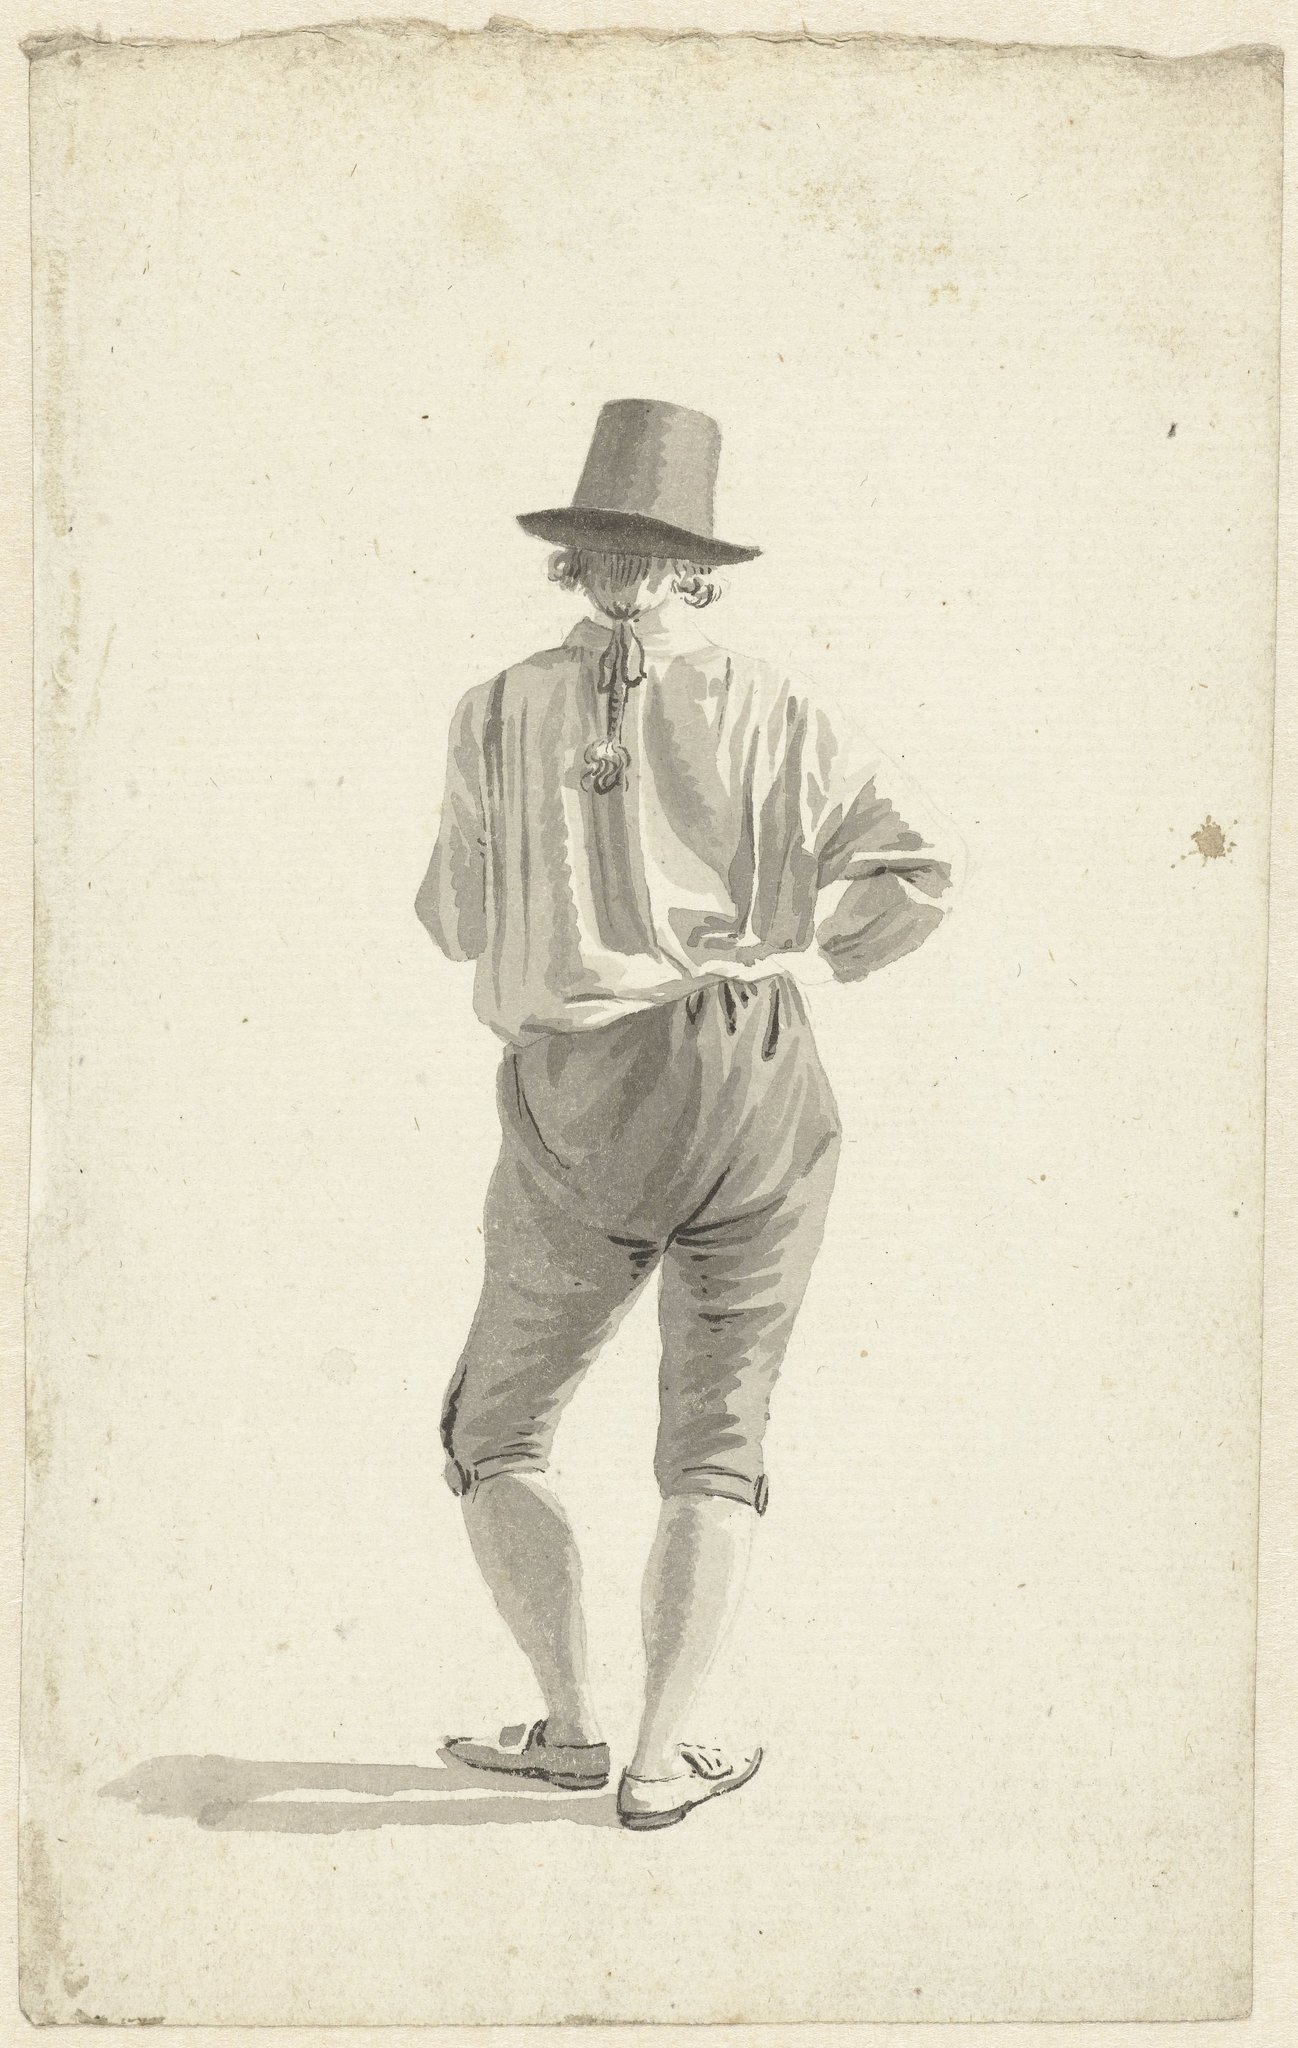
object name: drawing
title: Staande jager, op de rug gezien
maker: abraham van strij (i)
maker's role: draughtsman, painter, print maker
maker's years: 1753-1826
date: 1763-1826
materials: ink, paper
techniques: brush, pen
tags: hunter, postures of the human figure